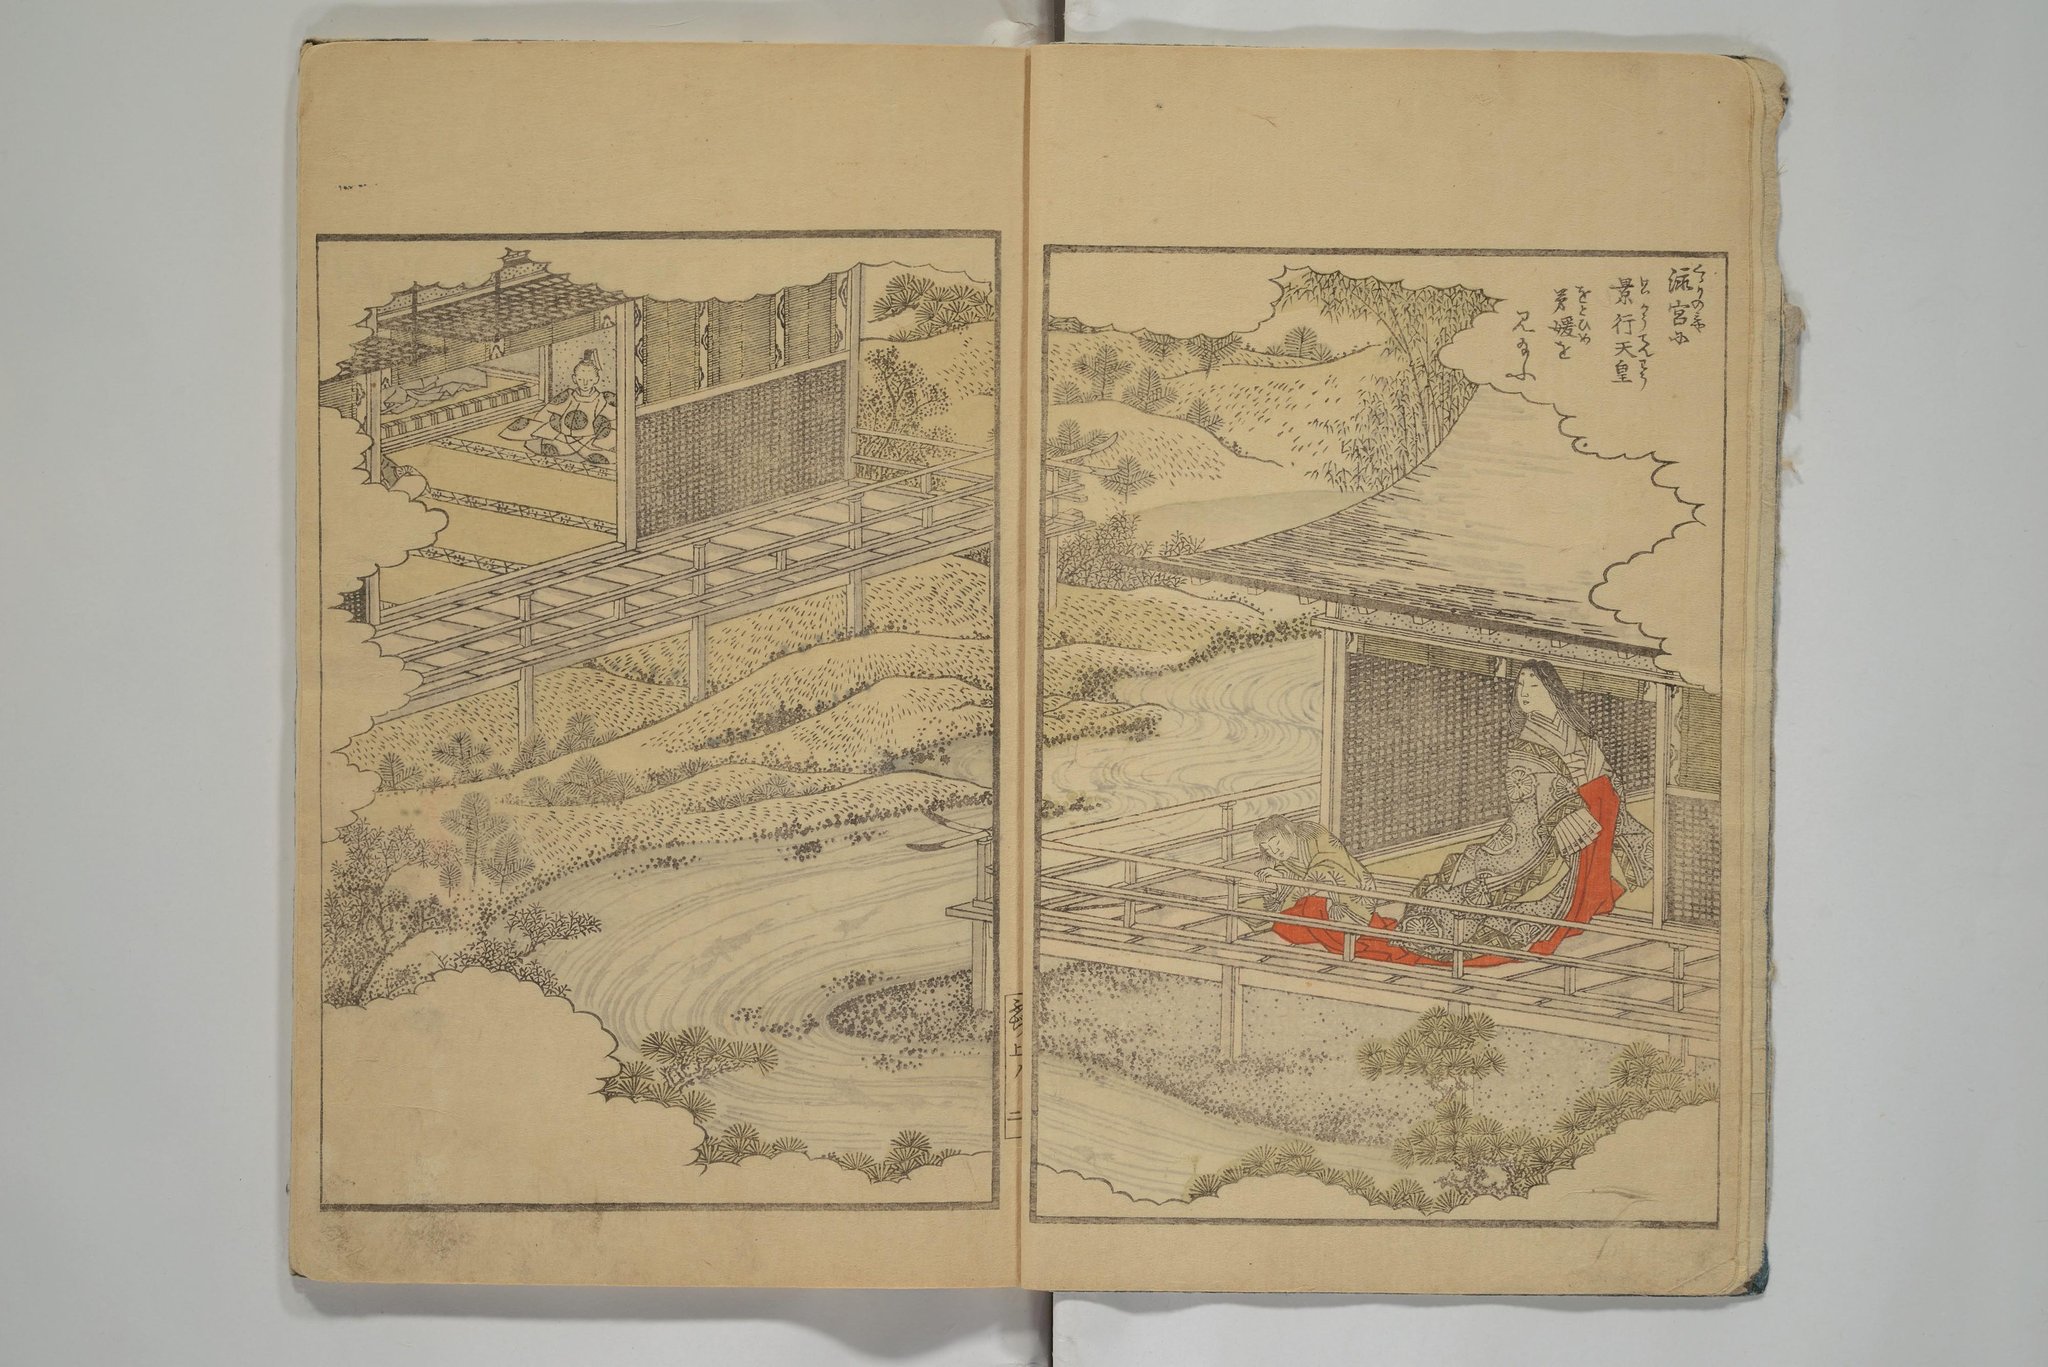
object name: illustrated book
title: Picture Book of the Wisteria Trousers (Ehon fujibakama) 絵本ふちはかま; えほんふじばかま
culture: japanese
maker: yanagawa shigenobu 柳川重信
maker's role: artist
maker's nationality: japanese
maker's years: 1787-1832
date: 1823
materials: ink, paper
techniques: woodblock print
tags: houses,boys,women